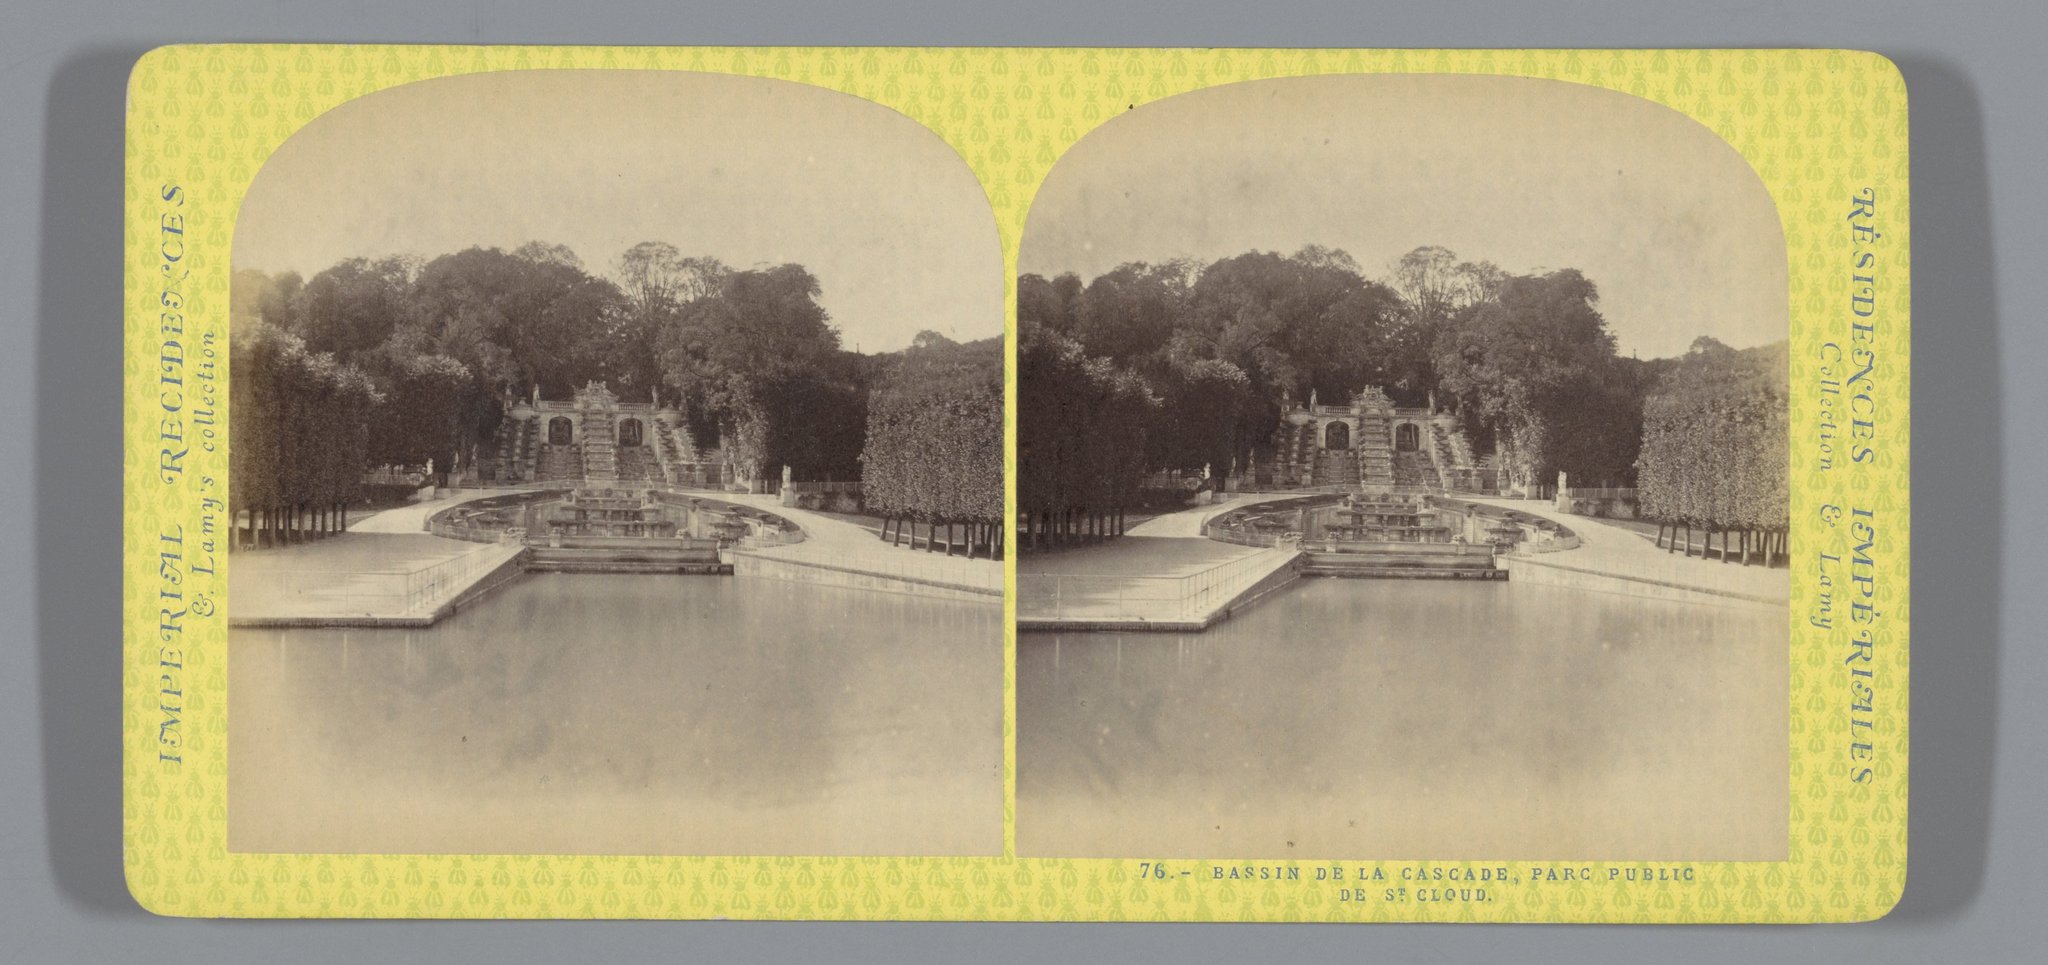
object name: stereograph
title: Gezicht op een vijver met een waterval in het Parc de Saint-Cloud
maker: ernest eléonor pierre lamy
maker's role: publisher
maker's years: 1828-1900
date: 1860-1870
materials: cardboard, photographic support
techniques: albumen print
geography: parc de saint-cloud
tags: garden pond, garden cascade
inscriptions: inscription: ‘E. Lamy's collection’, number: ‘76.’